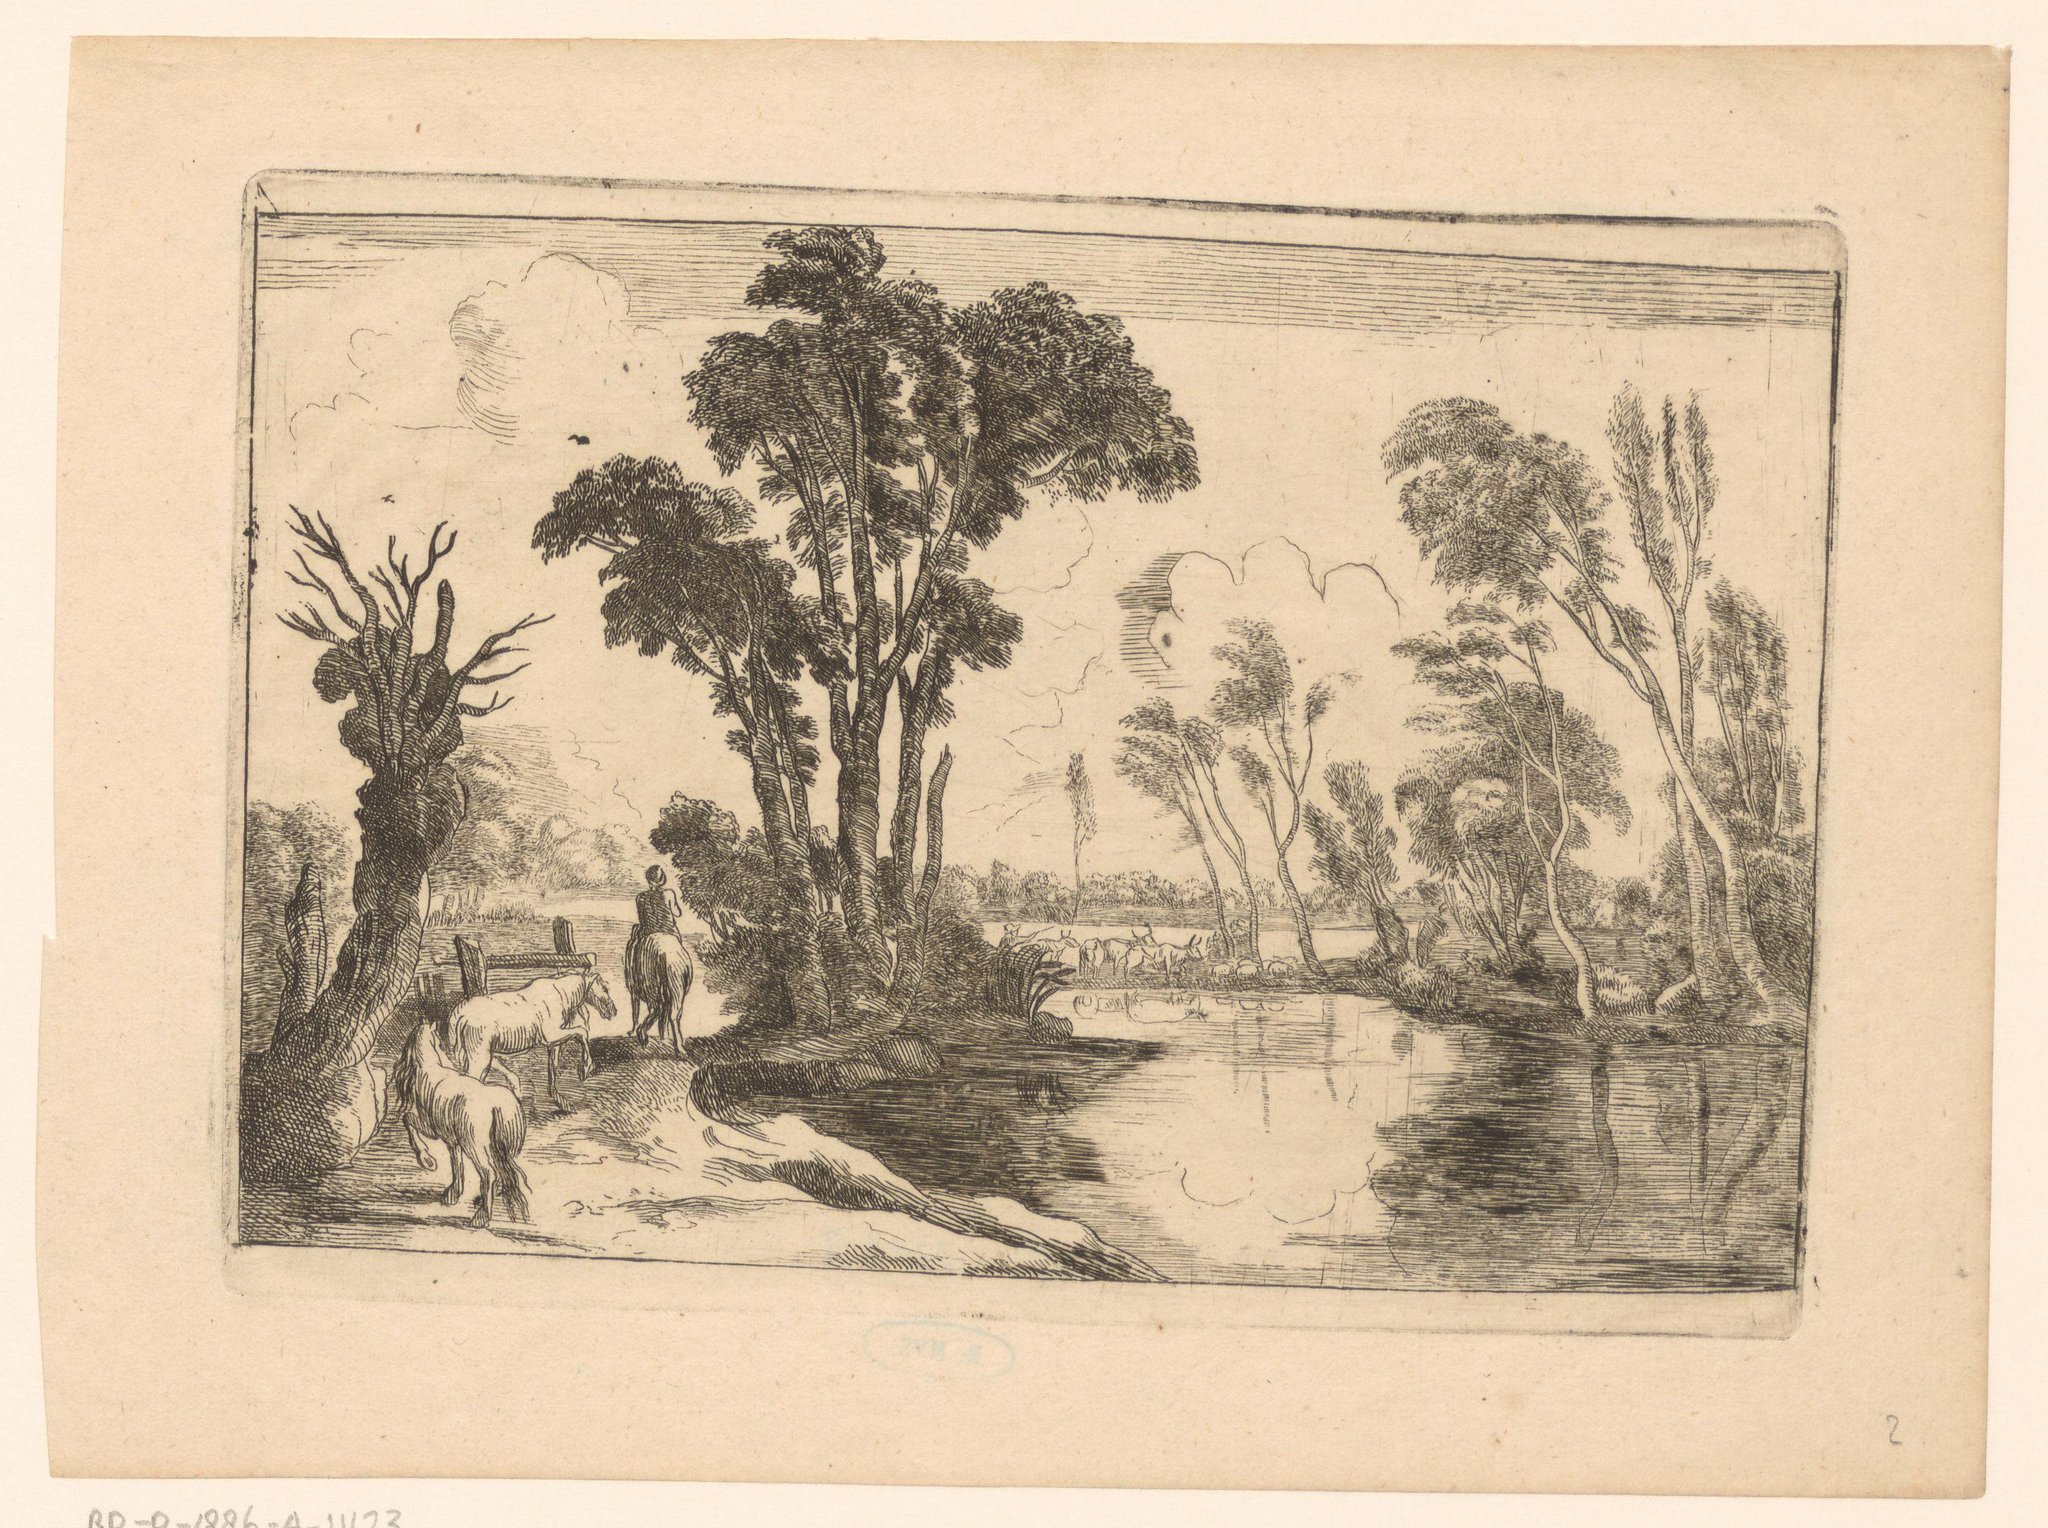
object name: print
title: Landschap met ruiter en twee paarden die langs een meer lopen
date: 1649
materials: paper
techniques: etching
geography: london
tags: riding a horse, ass, or mule; rider, horseman, herding, herdsman, herdswoman, shepherd, shepherdess, cowherd, etc., lake, herd, flock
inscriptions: collector's mark: Lugt 2228